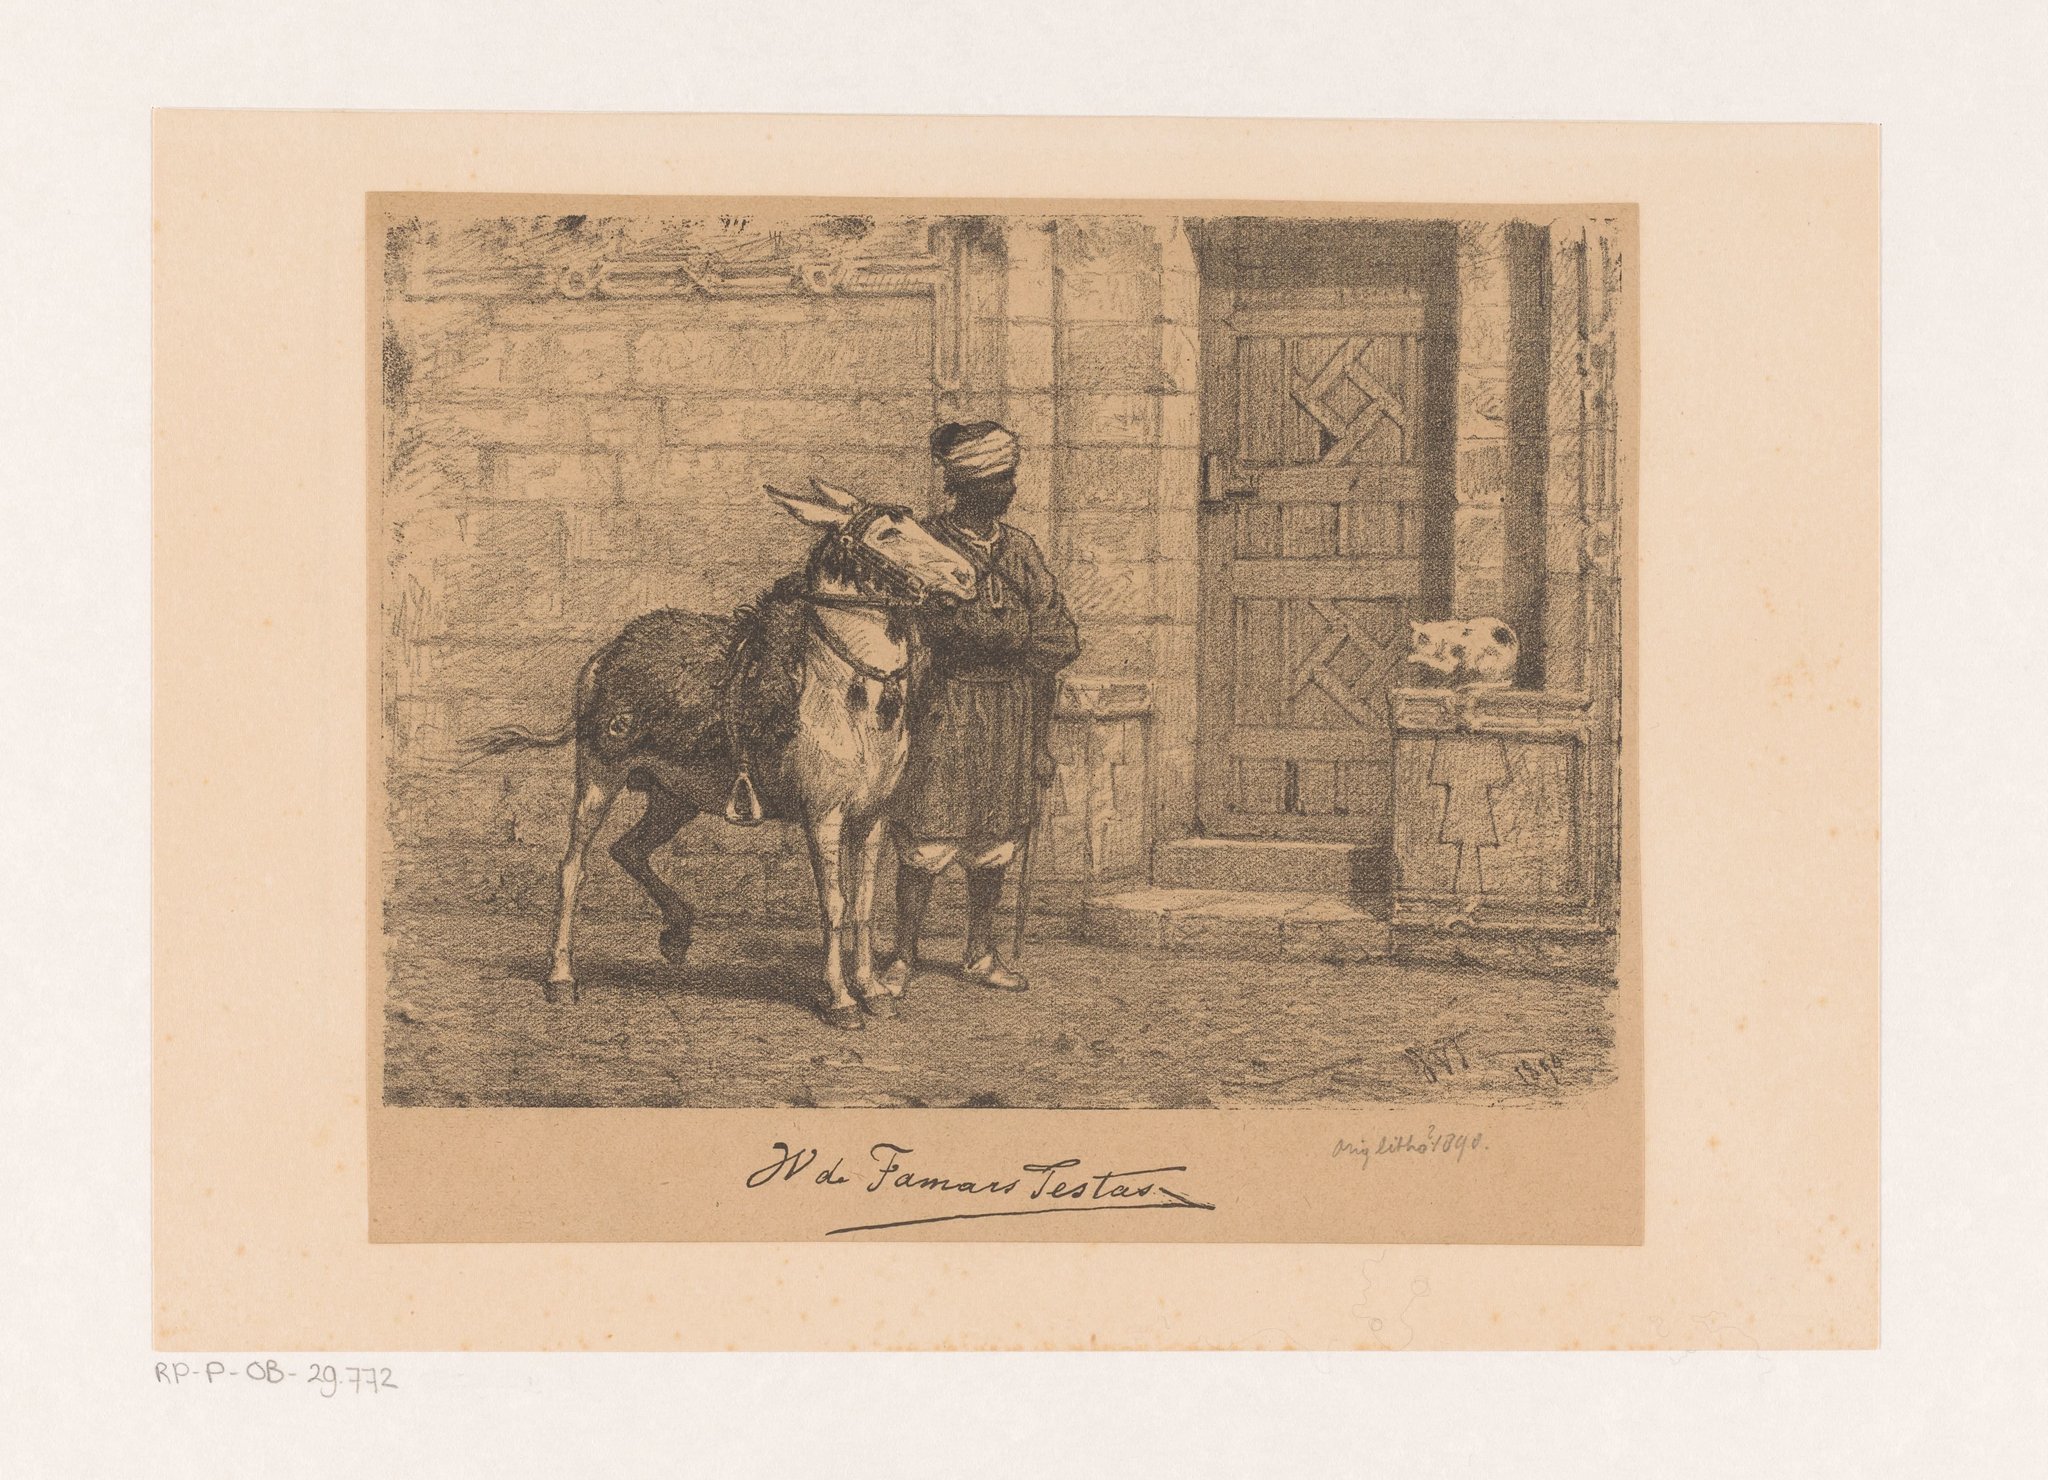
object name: print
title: Man met ezel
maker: willem de famars testas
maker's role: draughtsman, painter, print maker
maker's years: 1834-1896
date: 1890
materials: paper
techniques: lithograph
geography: netherlands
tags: ass, donkey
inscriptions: collector's mark: Lugt 2228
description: Een zwarte man met tulband staat met een ezel voor een gesloten deur.